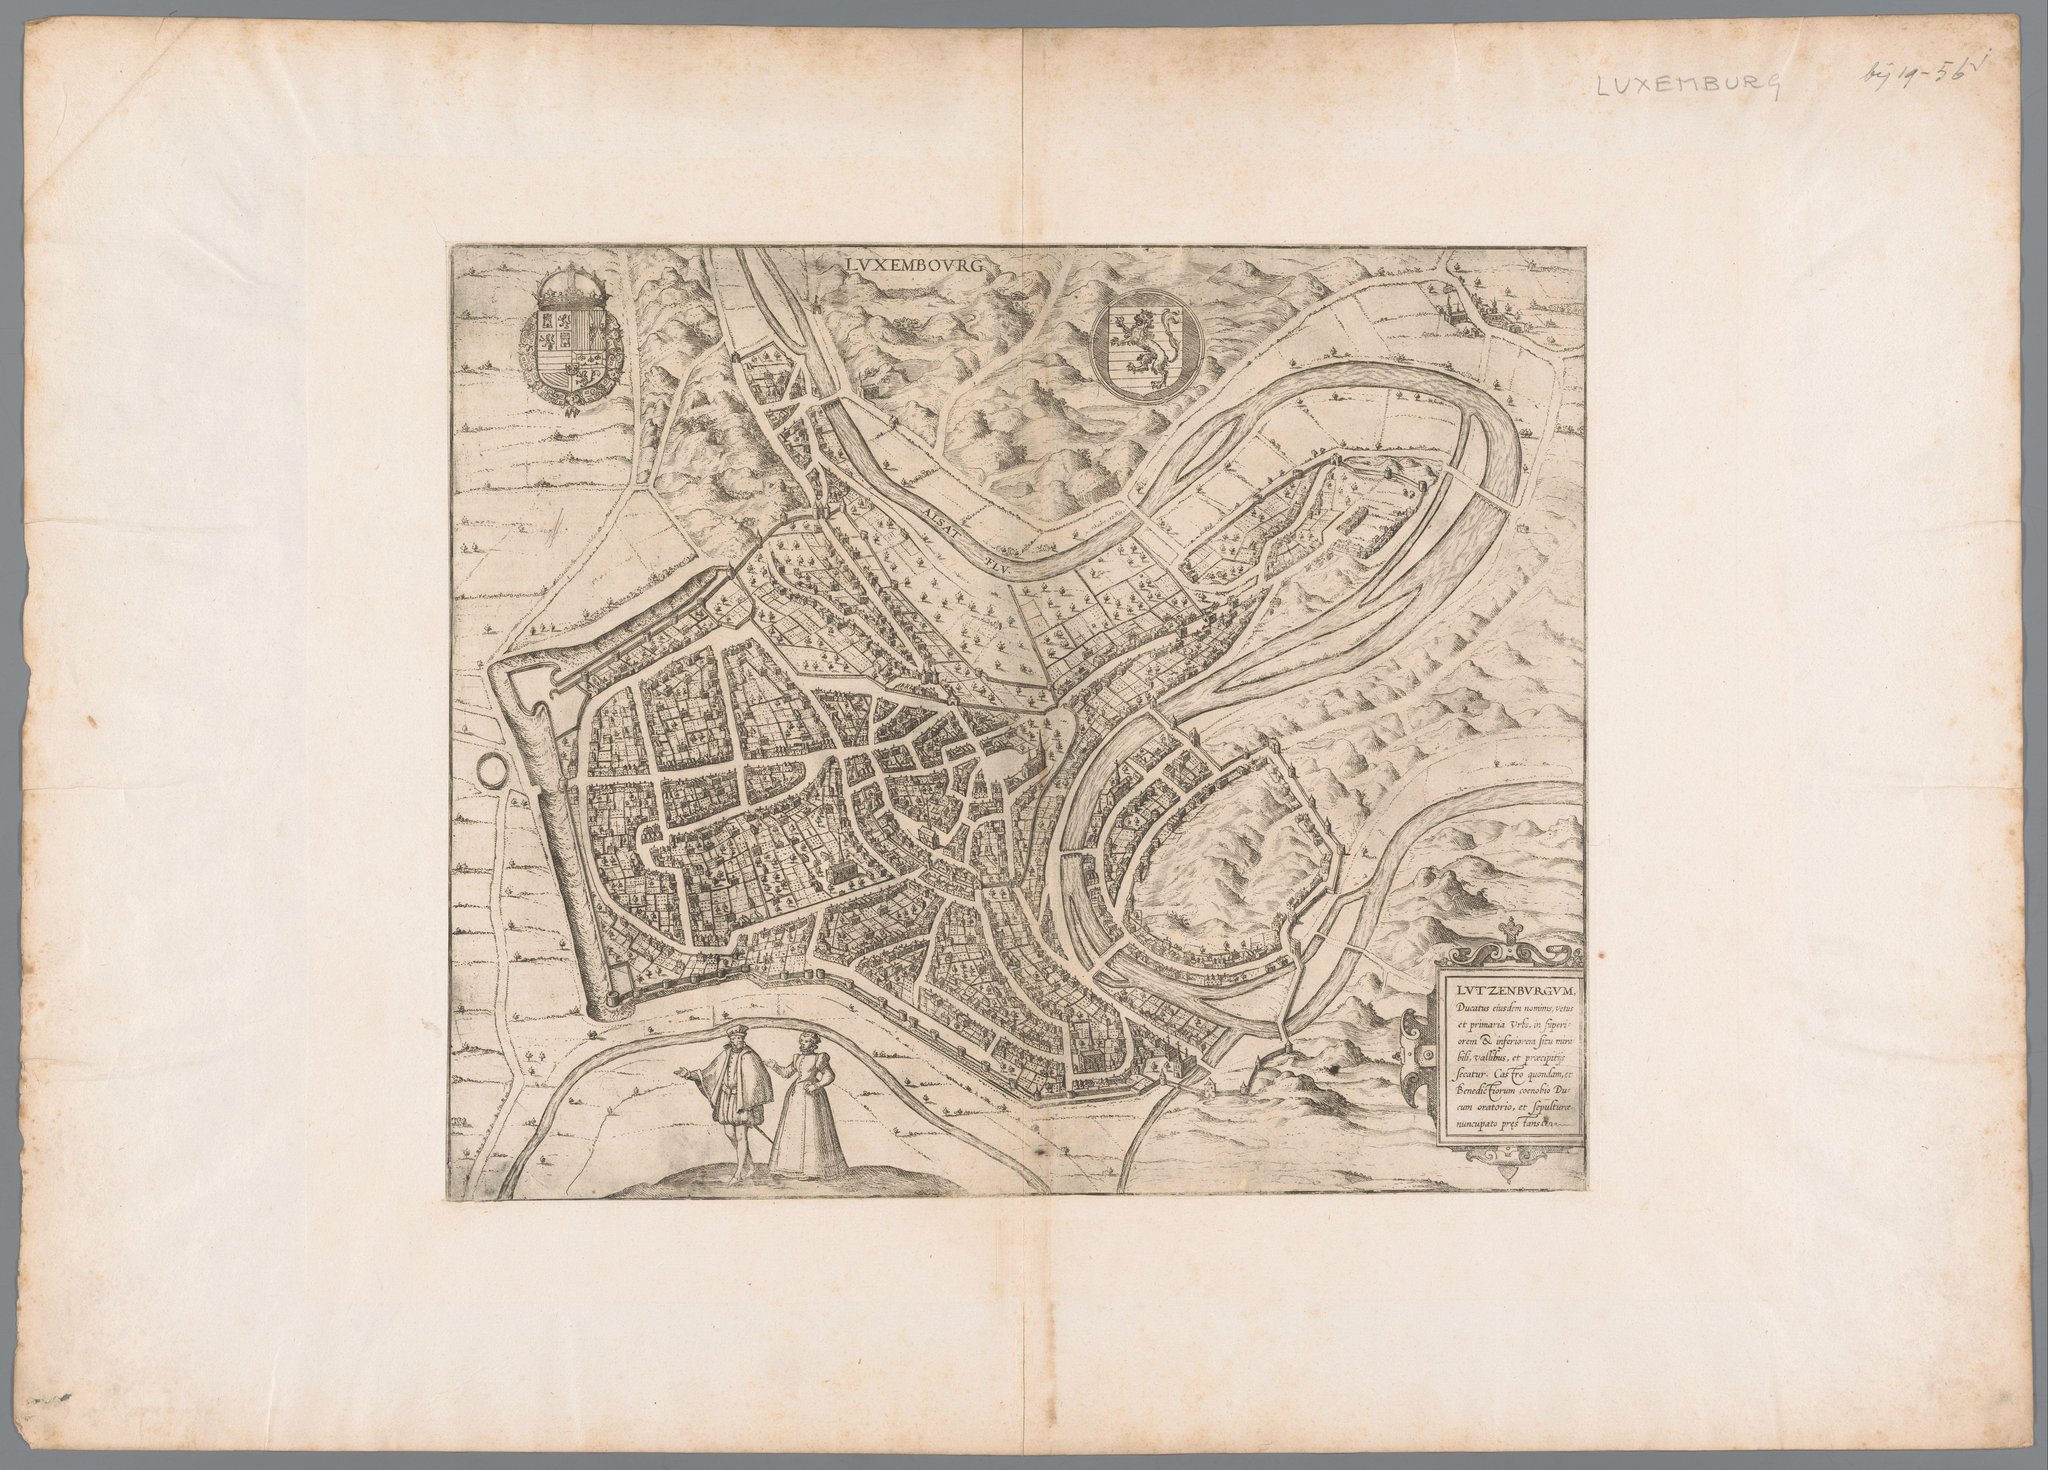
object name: area plan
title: Plattegrond van Luxemburg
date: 1616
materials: paper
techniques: etching, letterpress printing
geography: cologne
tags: maps of cities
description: Prent uit: Braun, Georg. Civitates orbis terrarum (...), 6 dln. Keulen: Peter von Brachel, 1612-1616, dl. 3, nr. 16.